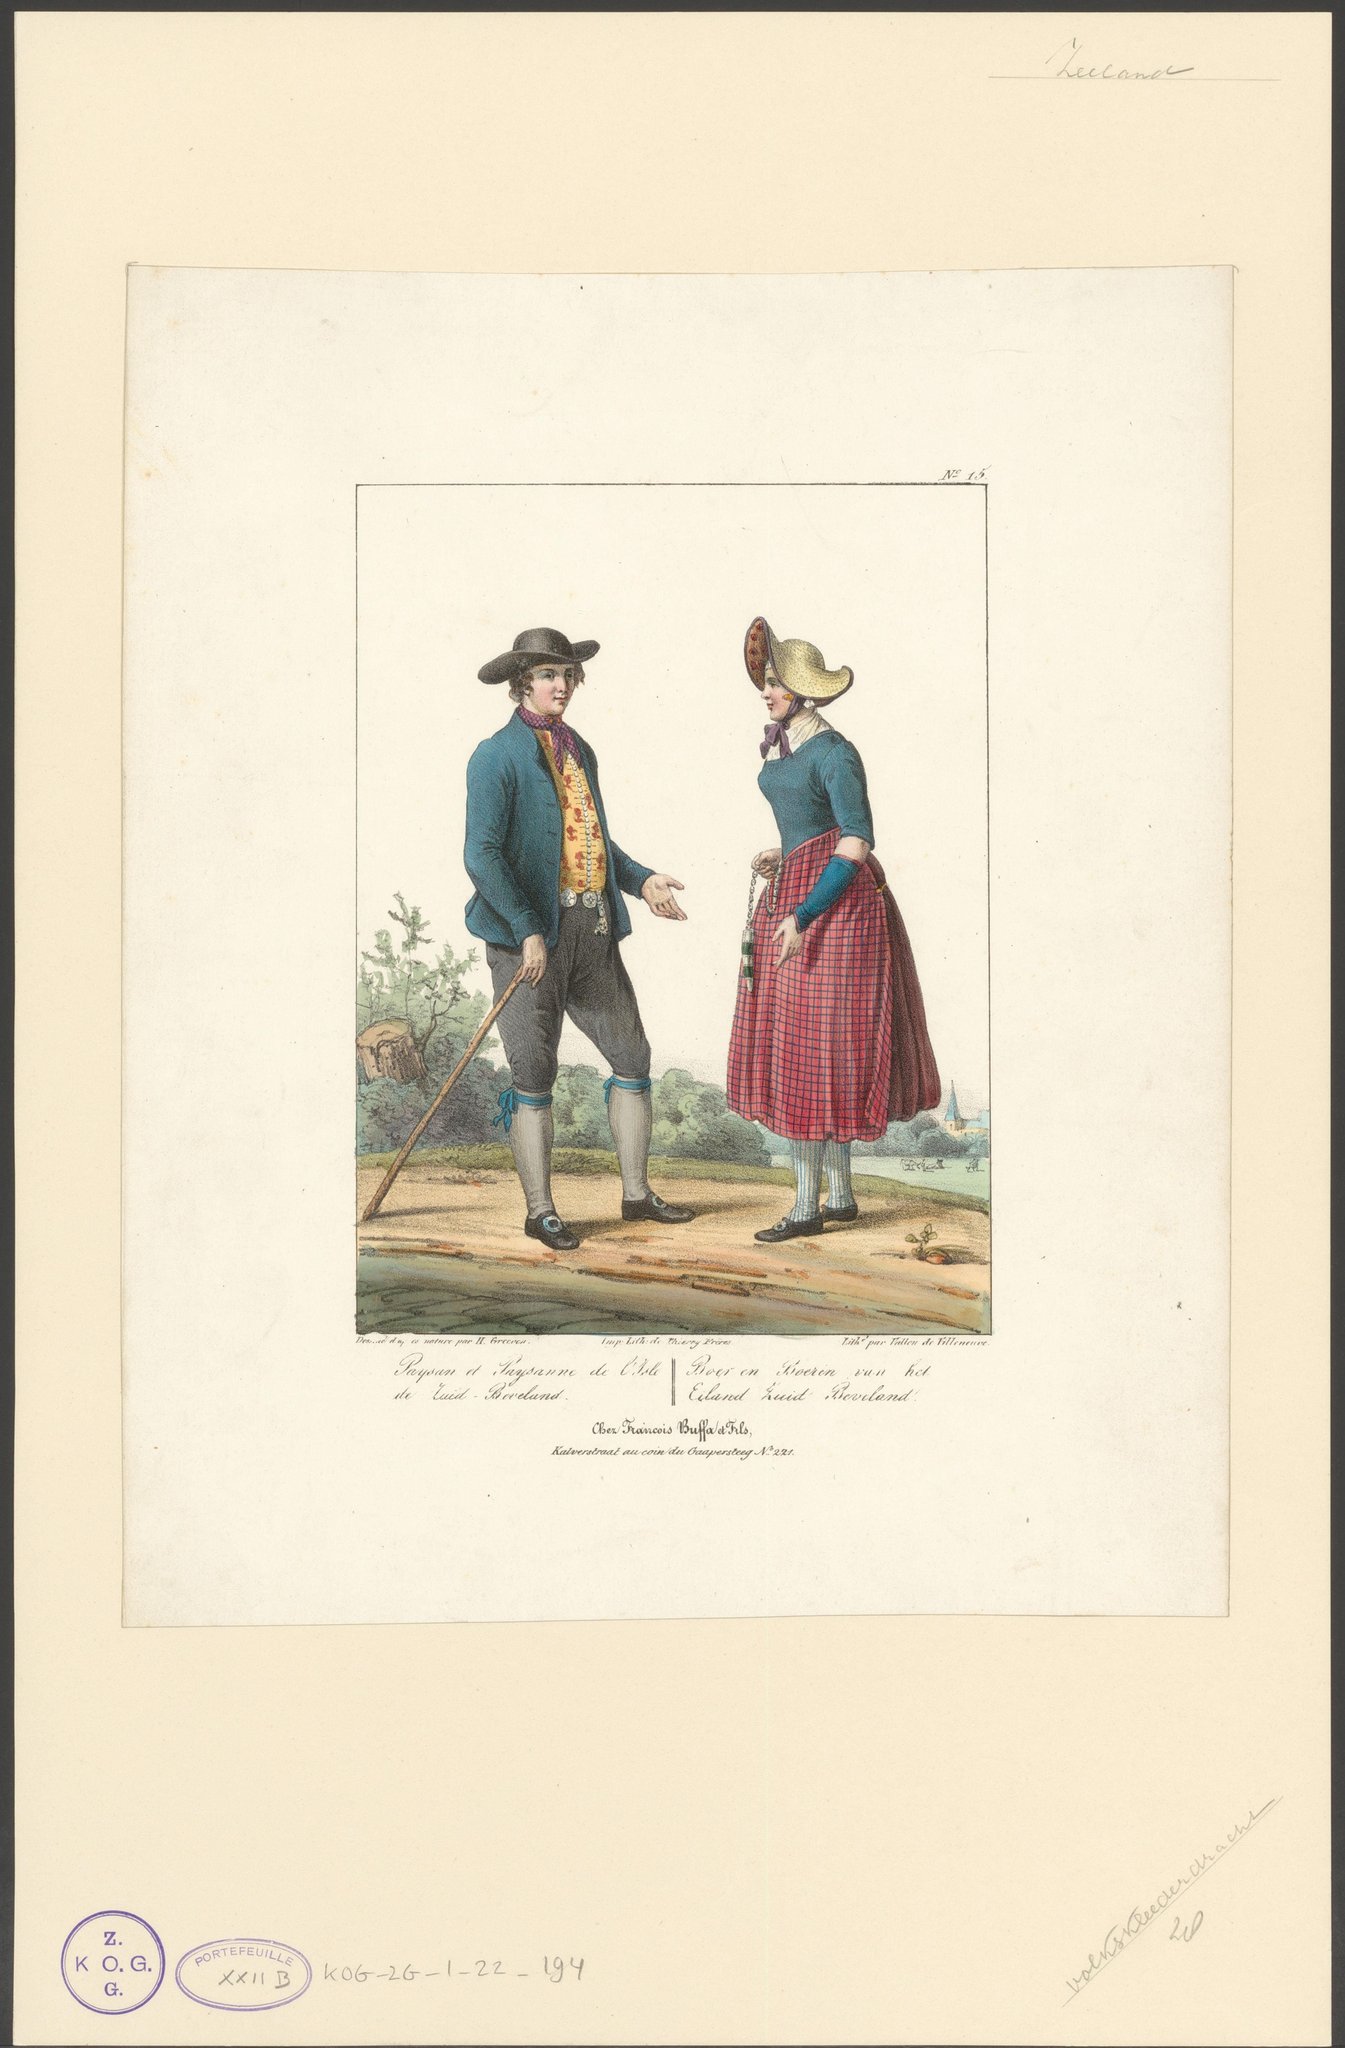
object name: print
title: Klederdracht van Zuid-Beveland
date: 1828-1835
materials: paper, watercolor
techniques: hand coloring, lithograph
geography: netherlands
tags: farmers, farmers - aa - female farmer, farmer's wife, clothes, costume (+ women's clothes), clothes, costume (+ men's clothes), folk costume, regional costume, zeeland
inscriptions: collector's mark: Lugt 1641, collector's mark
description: Eerst gebruikt als illustratie in: Collection des Costumes des Provinces Septentrionales du Royaume des Pays-Bas, Dessinés d'après Nature par H. Greeven et lithographiés par Vallon de Villeneuve. Amsterdam: Chez François Buffa et fils [en] Paris: Chez Engelmann et Cie., 1828 = Verzameling der Kleederdragten in de Nordelijke Provincien van het Koningrijk der Nederlanden, naar het leven geteekend door H. Greeven, op steen gebragt door Vallon de Villeneuve. The Amsterdam bij Frans Buffa et Zoonen [en] Parijs bij Engelmann et Cie., 1828. Dit exemplar is een andere, latere editie, zonder de samenwerking met Engelmann in Parijs.